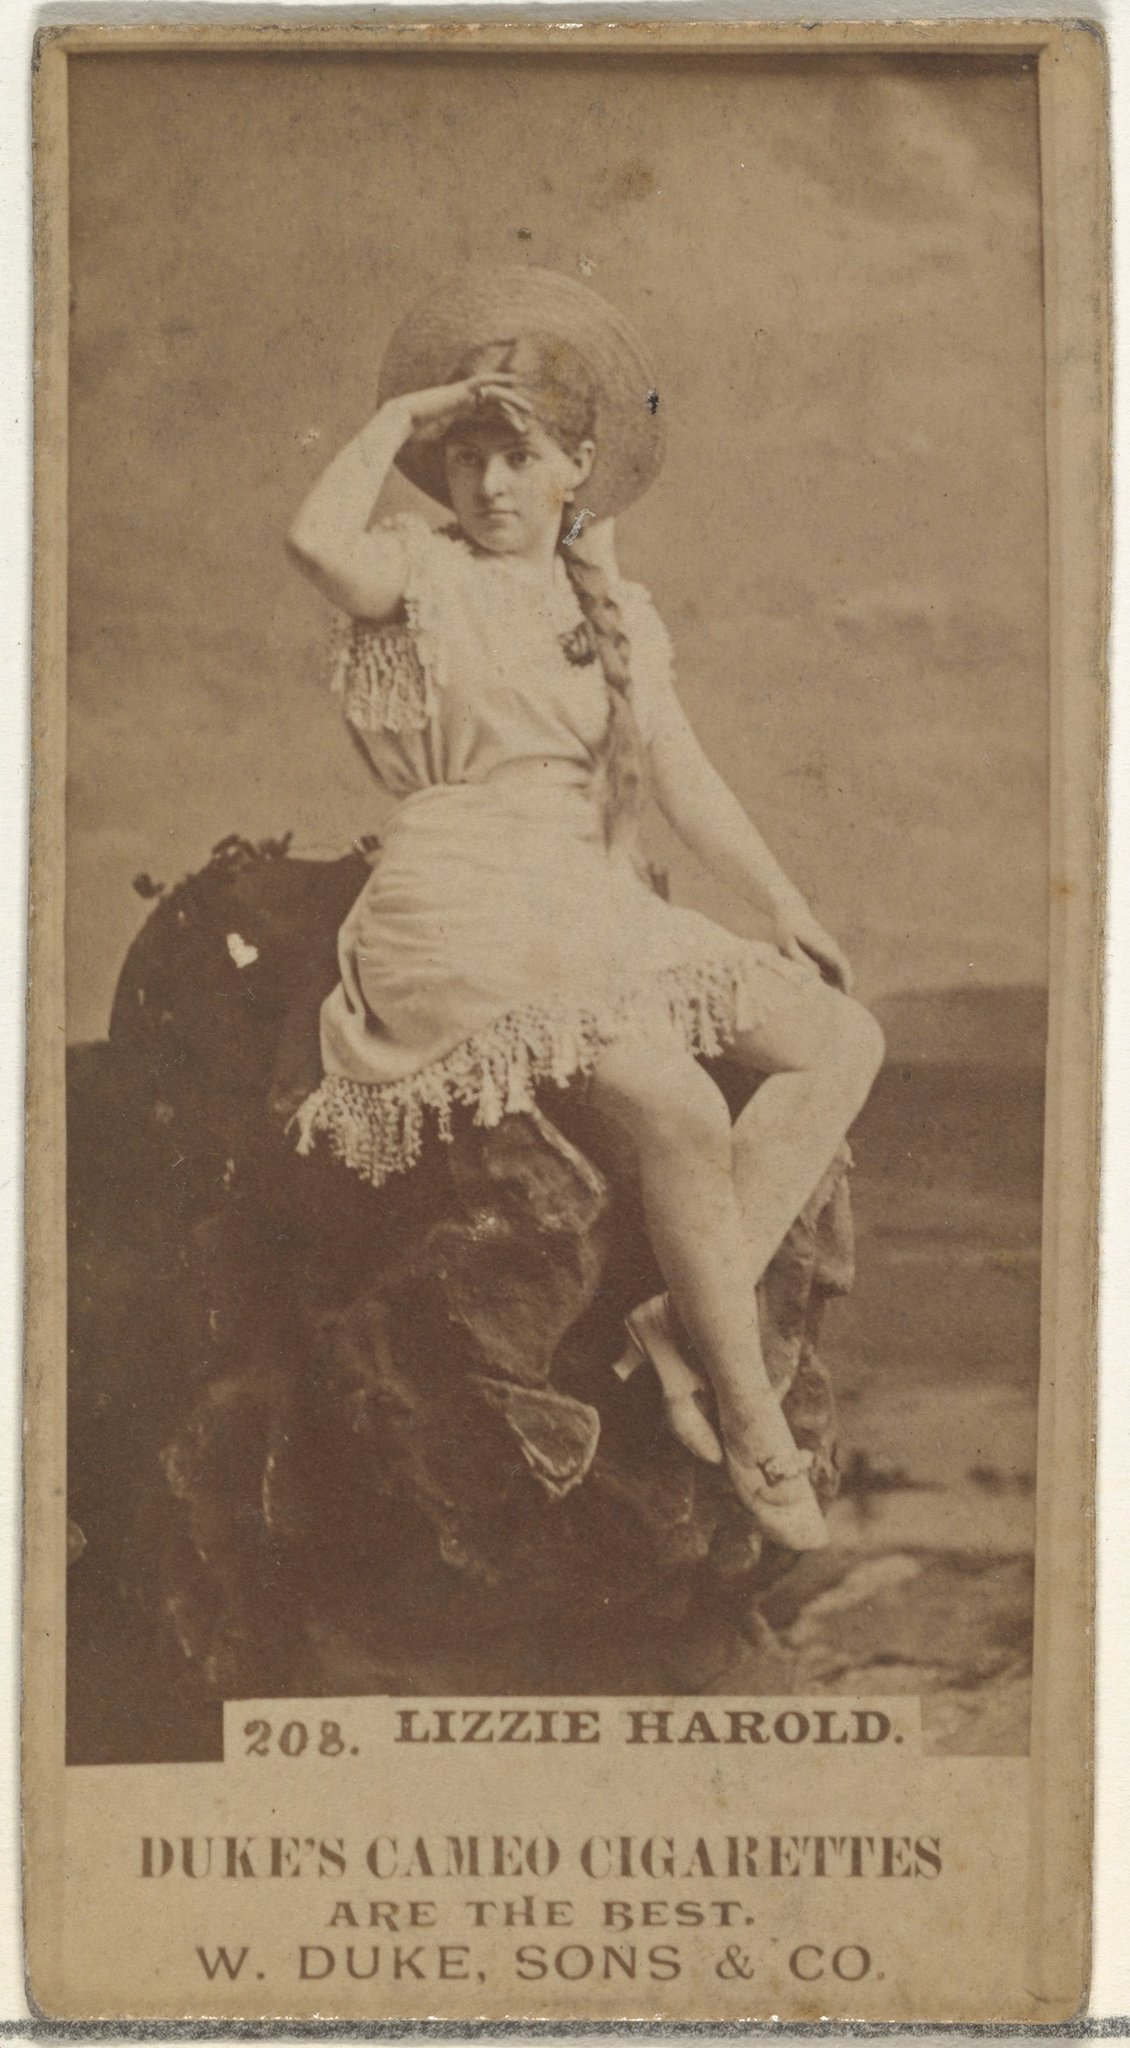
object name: photograph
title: Card Number 208, Lizzie Harold, from the Actors and Actresses series (N145-5) issued by Duke Sons & Co. to promote Cameo Cigarettes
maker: w. duke, sons & co.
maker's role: publisher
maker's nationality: american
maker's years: 1870-1920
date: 1880-1889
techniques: albumen silver print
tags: portraits,women,actresses